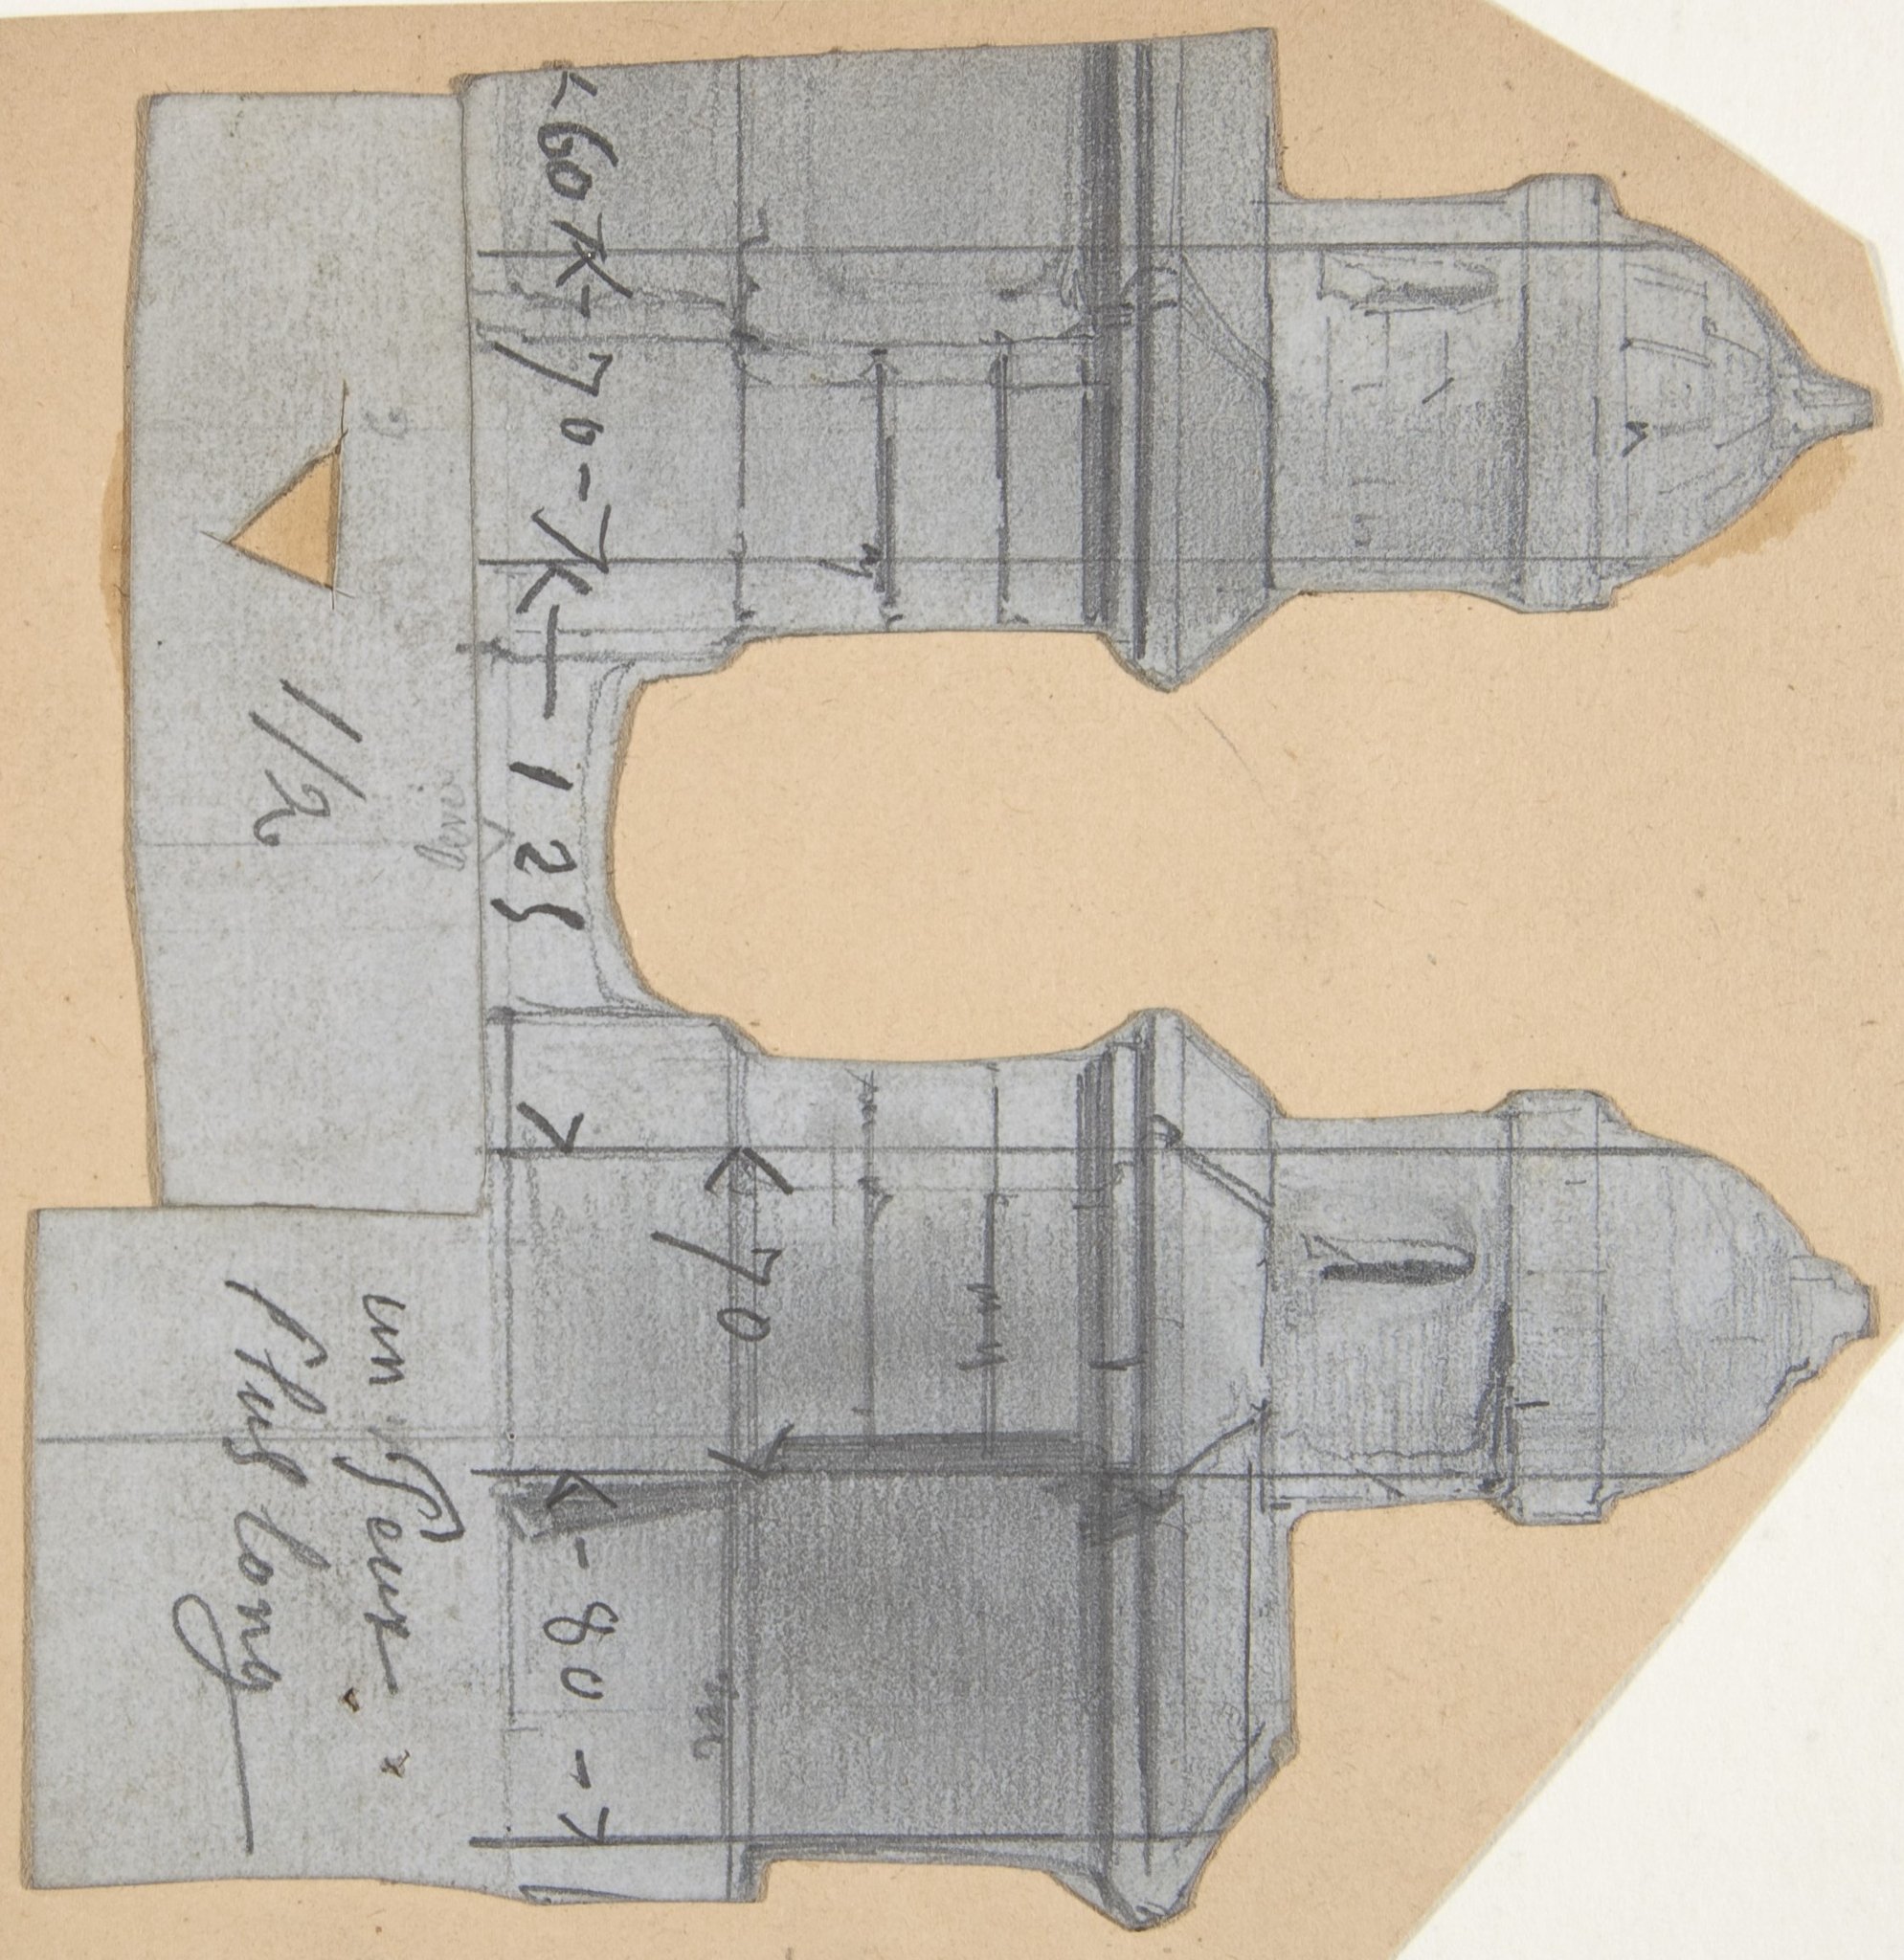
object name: drawing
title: Design for a Stage Set at the Opéra, Paris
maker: eugène cicéri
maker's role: artist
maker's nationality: french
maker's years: 1813-1890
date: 1830-1890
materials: graphite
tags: stage design